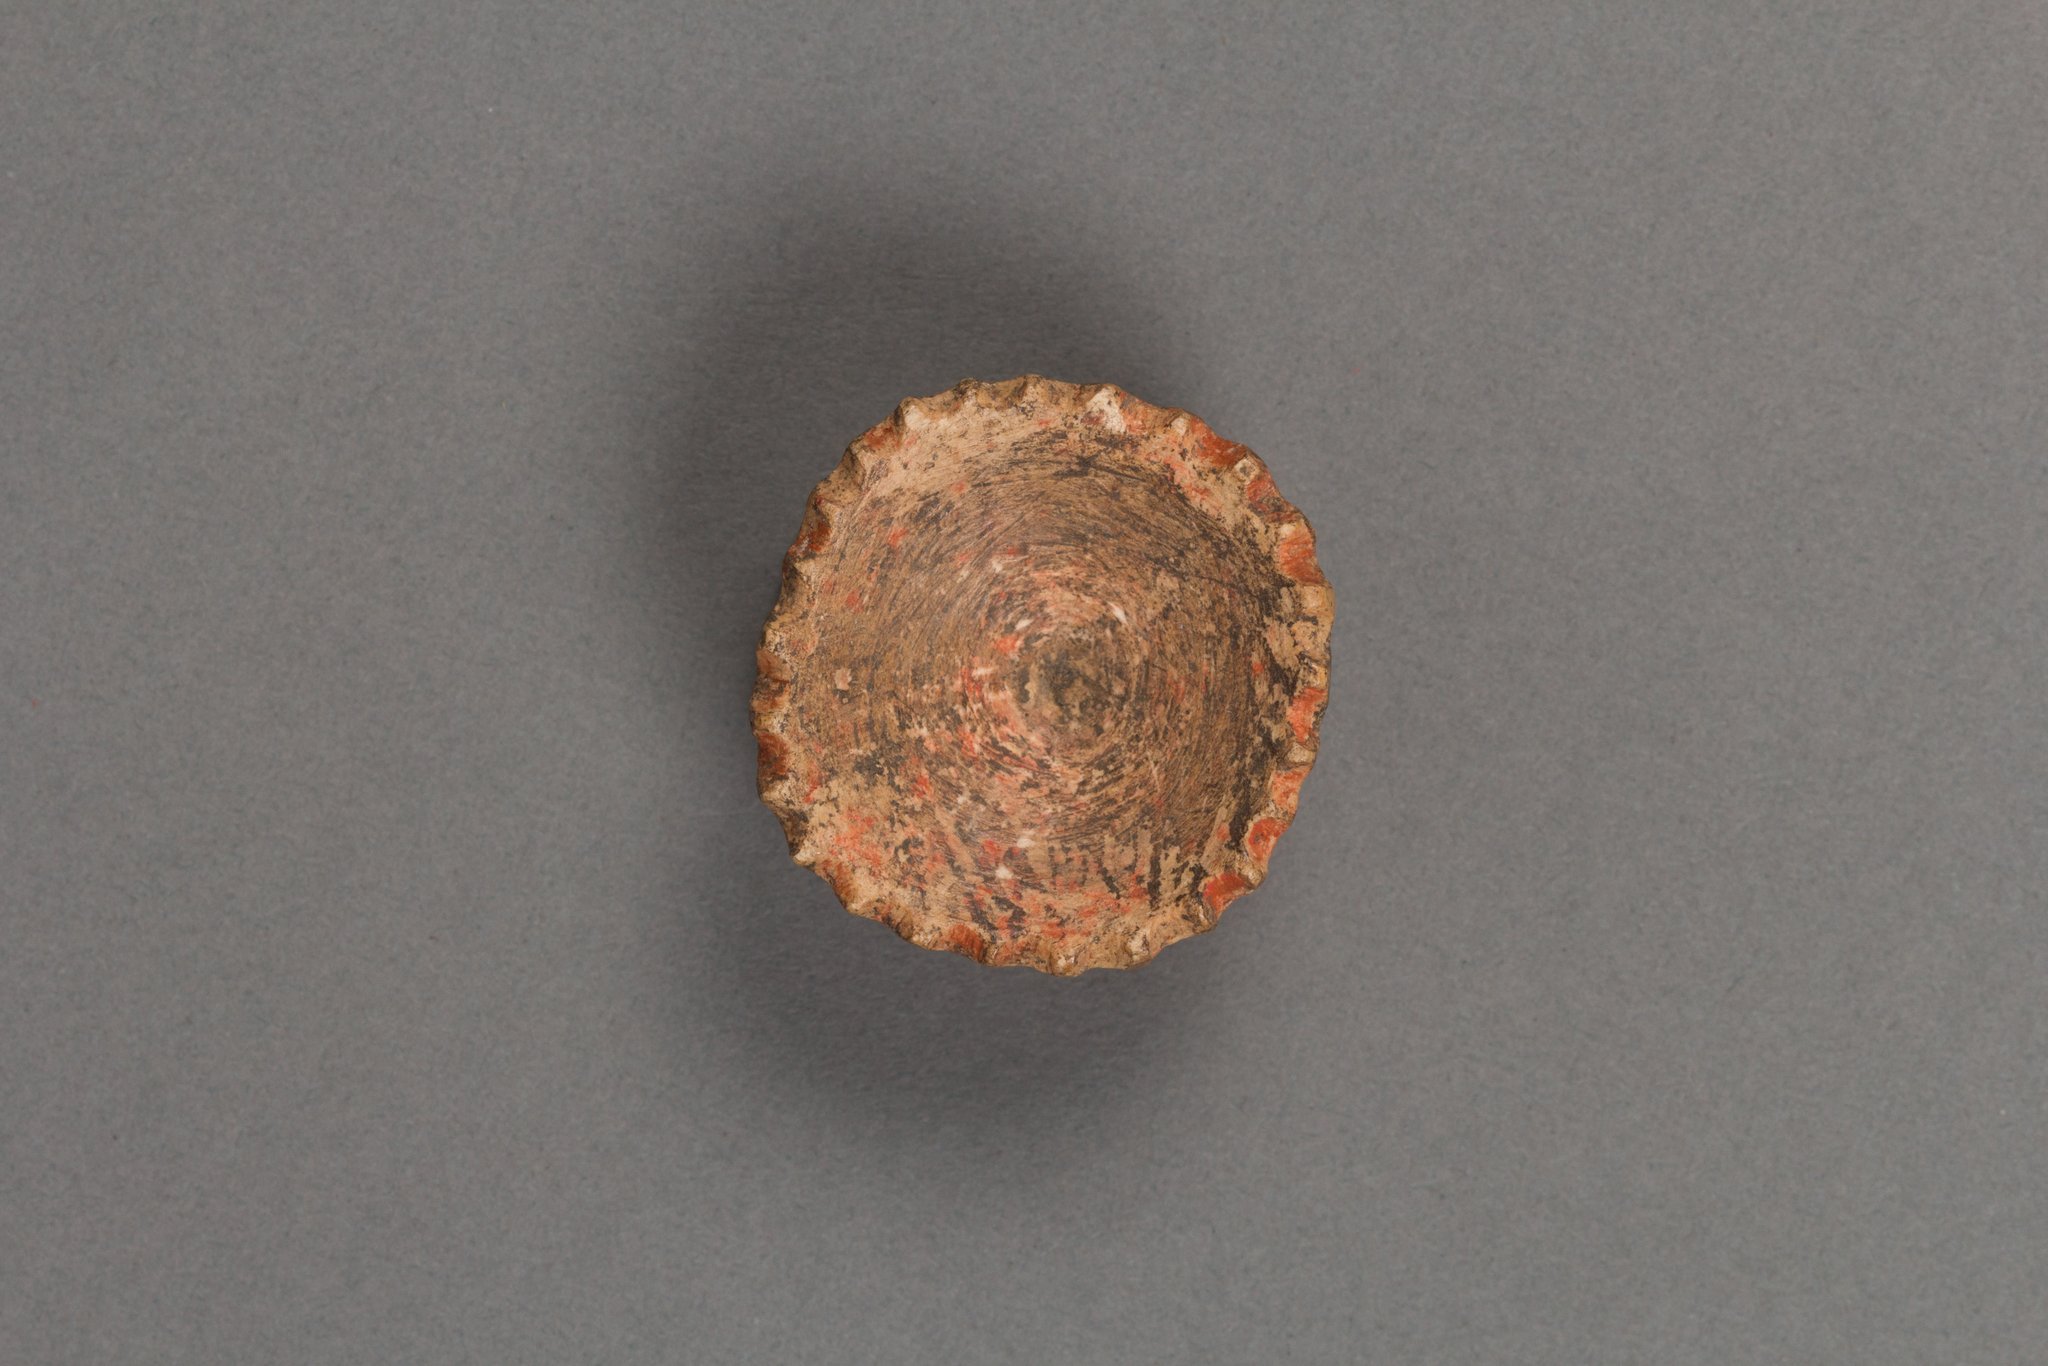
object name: ornament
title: One of a Group of Bone Ornaments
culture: japanese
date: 1000-300 BCE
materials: bone